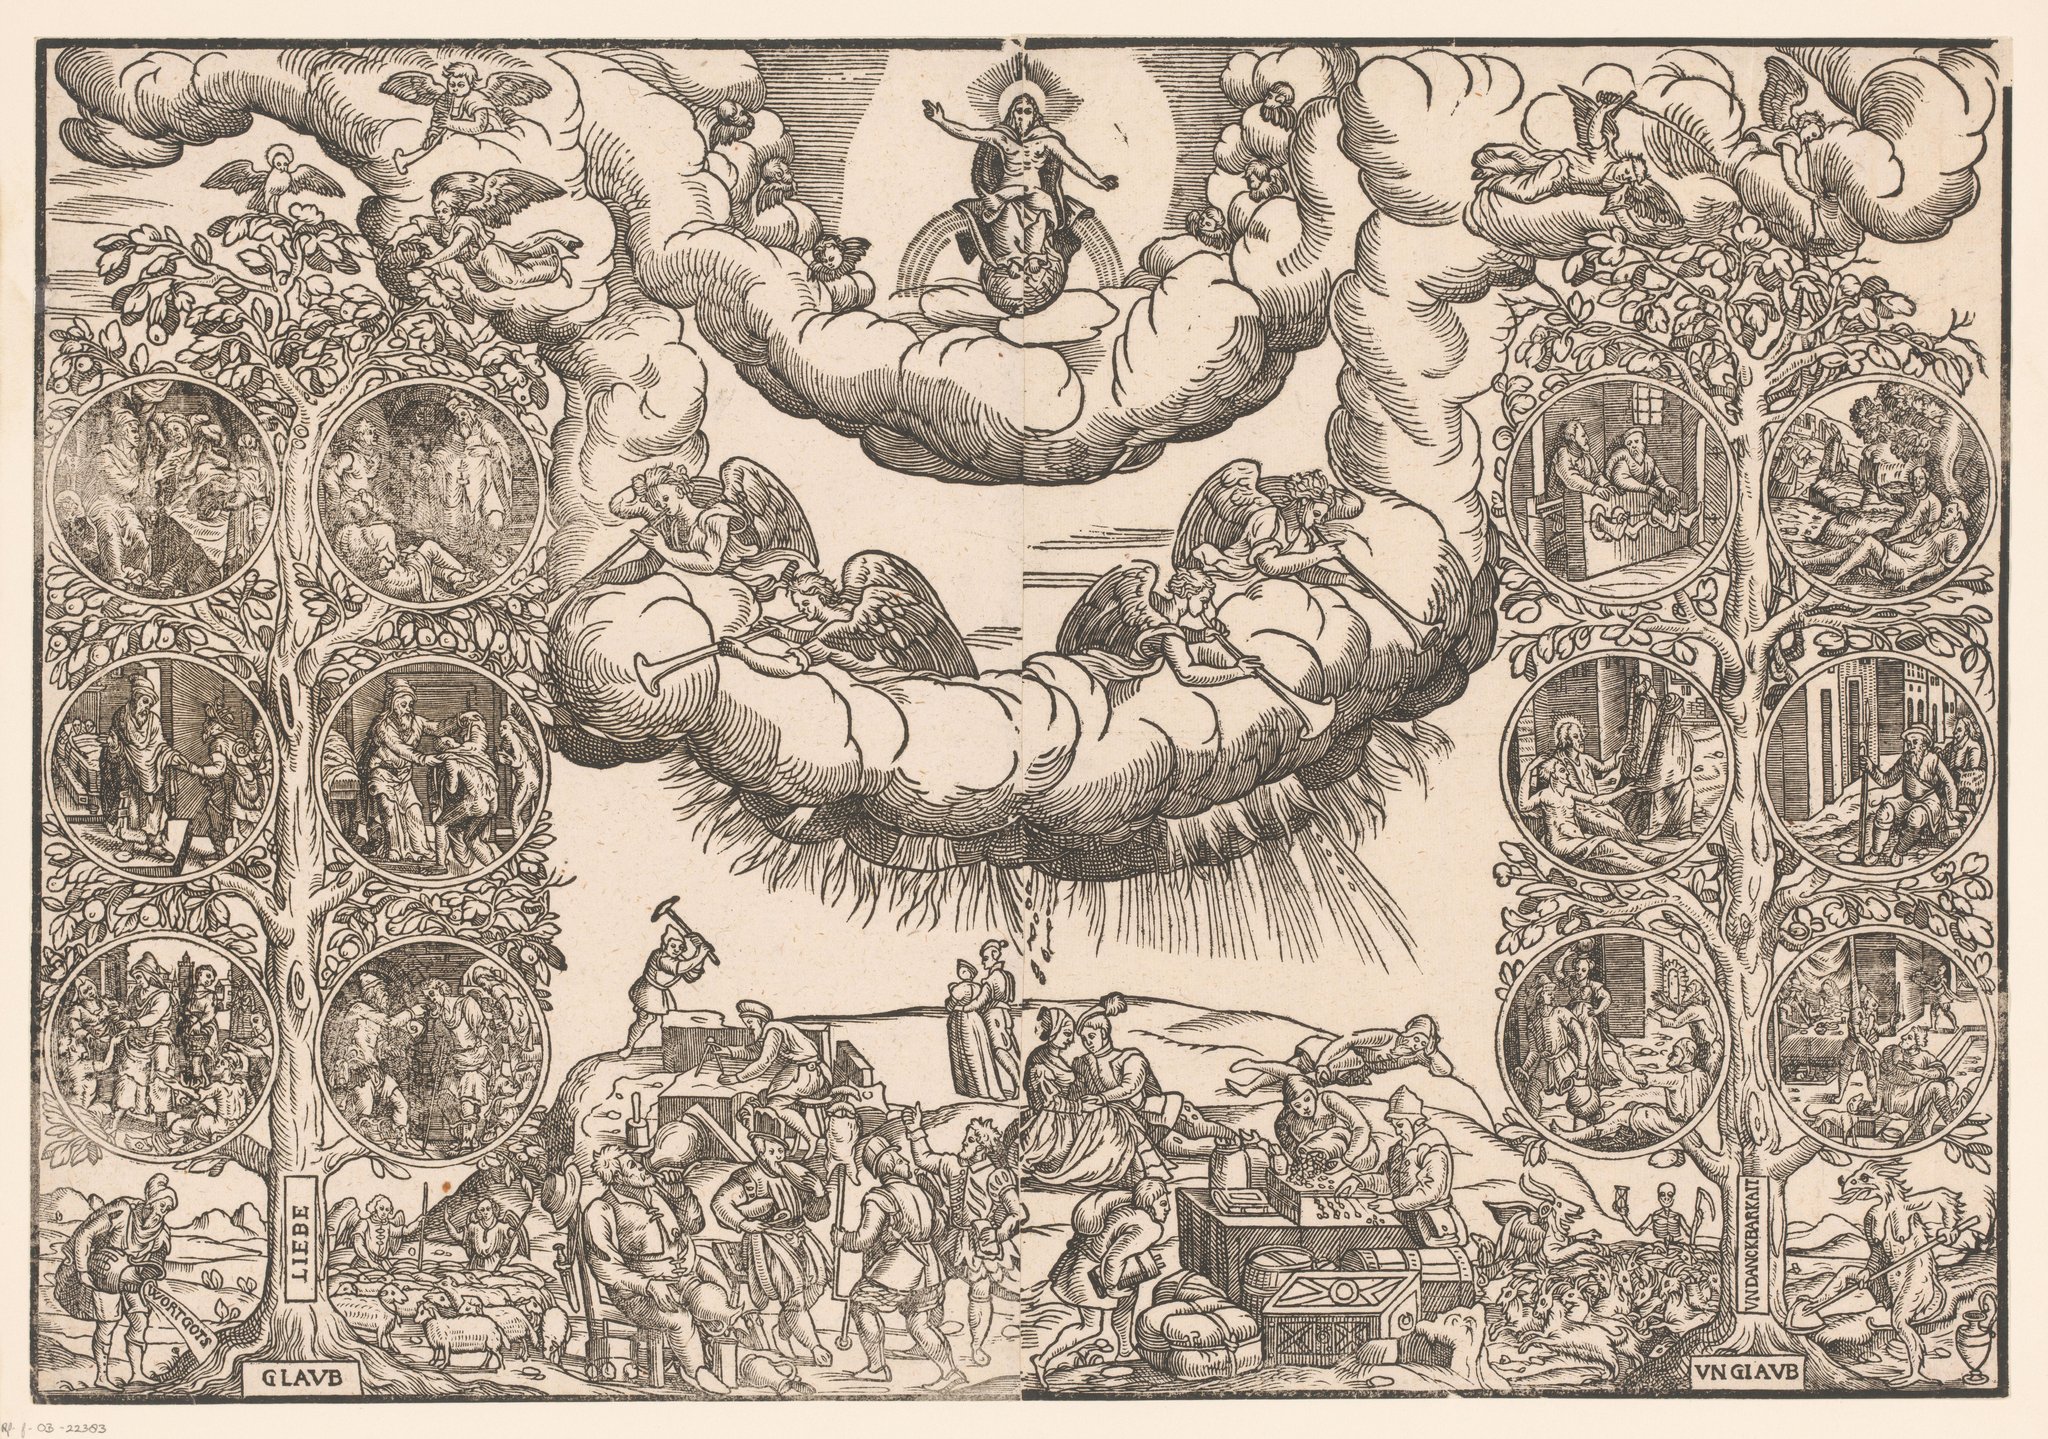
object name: print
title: Religieuze allegorie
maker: Anonymous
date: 1500-1599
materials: paper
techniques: woodcut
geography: germany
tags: faith, 'fides'; 'fede', 'fede catholica', 'fede christiana', 'fede christiana catholica' (ripa) ~ one of the three theological virtues, unbelief, 'infidelitas', the (seven) acts of mercy, tree as a scheme of relations, diagram in form of a tree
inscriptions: collector's mark: Lugt 2228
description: Tegenstelling tussen de boom van Liefde groeiend uit Geloof en de boom van Ondankbaarheid groeiend uit Ongeloof.